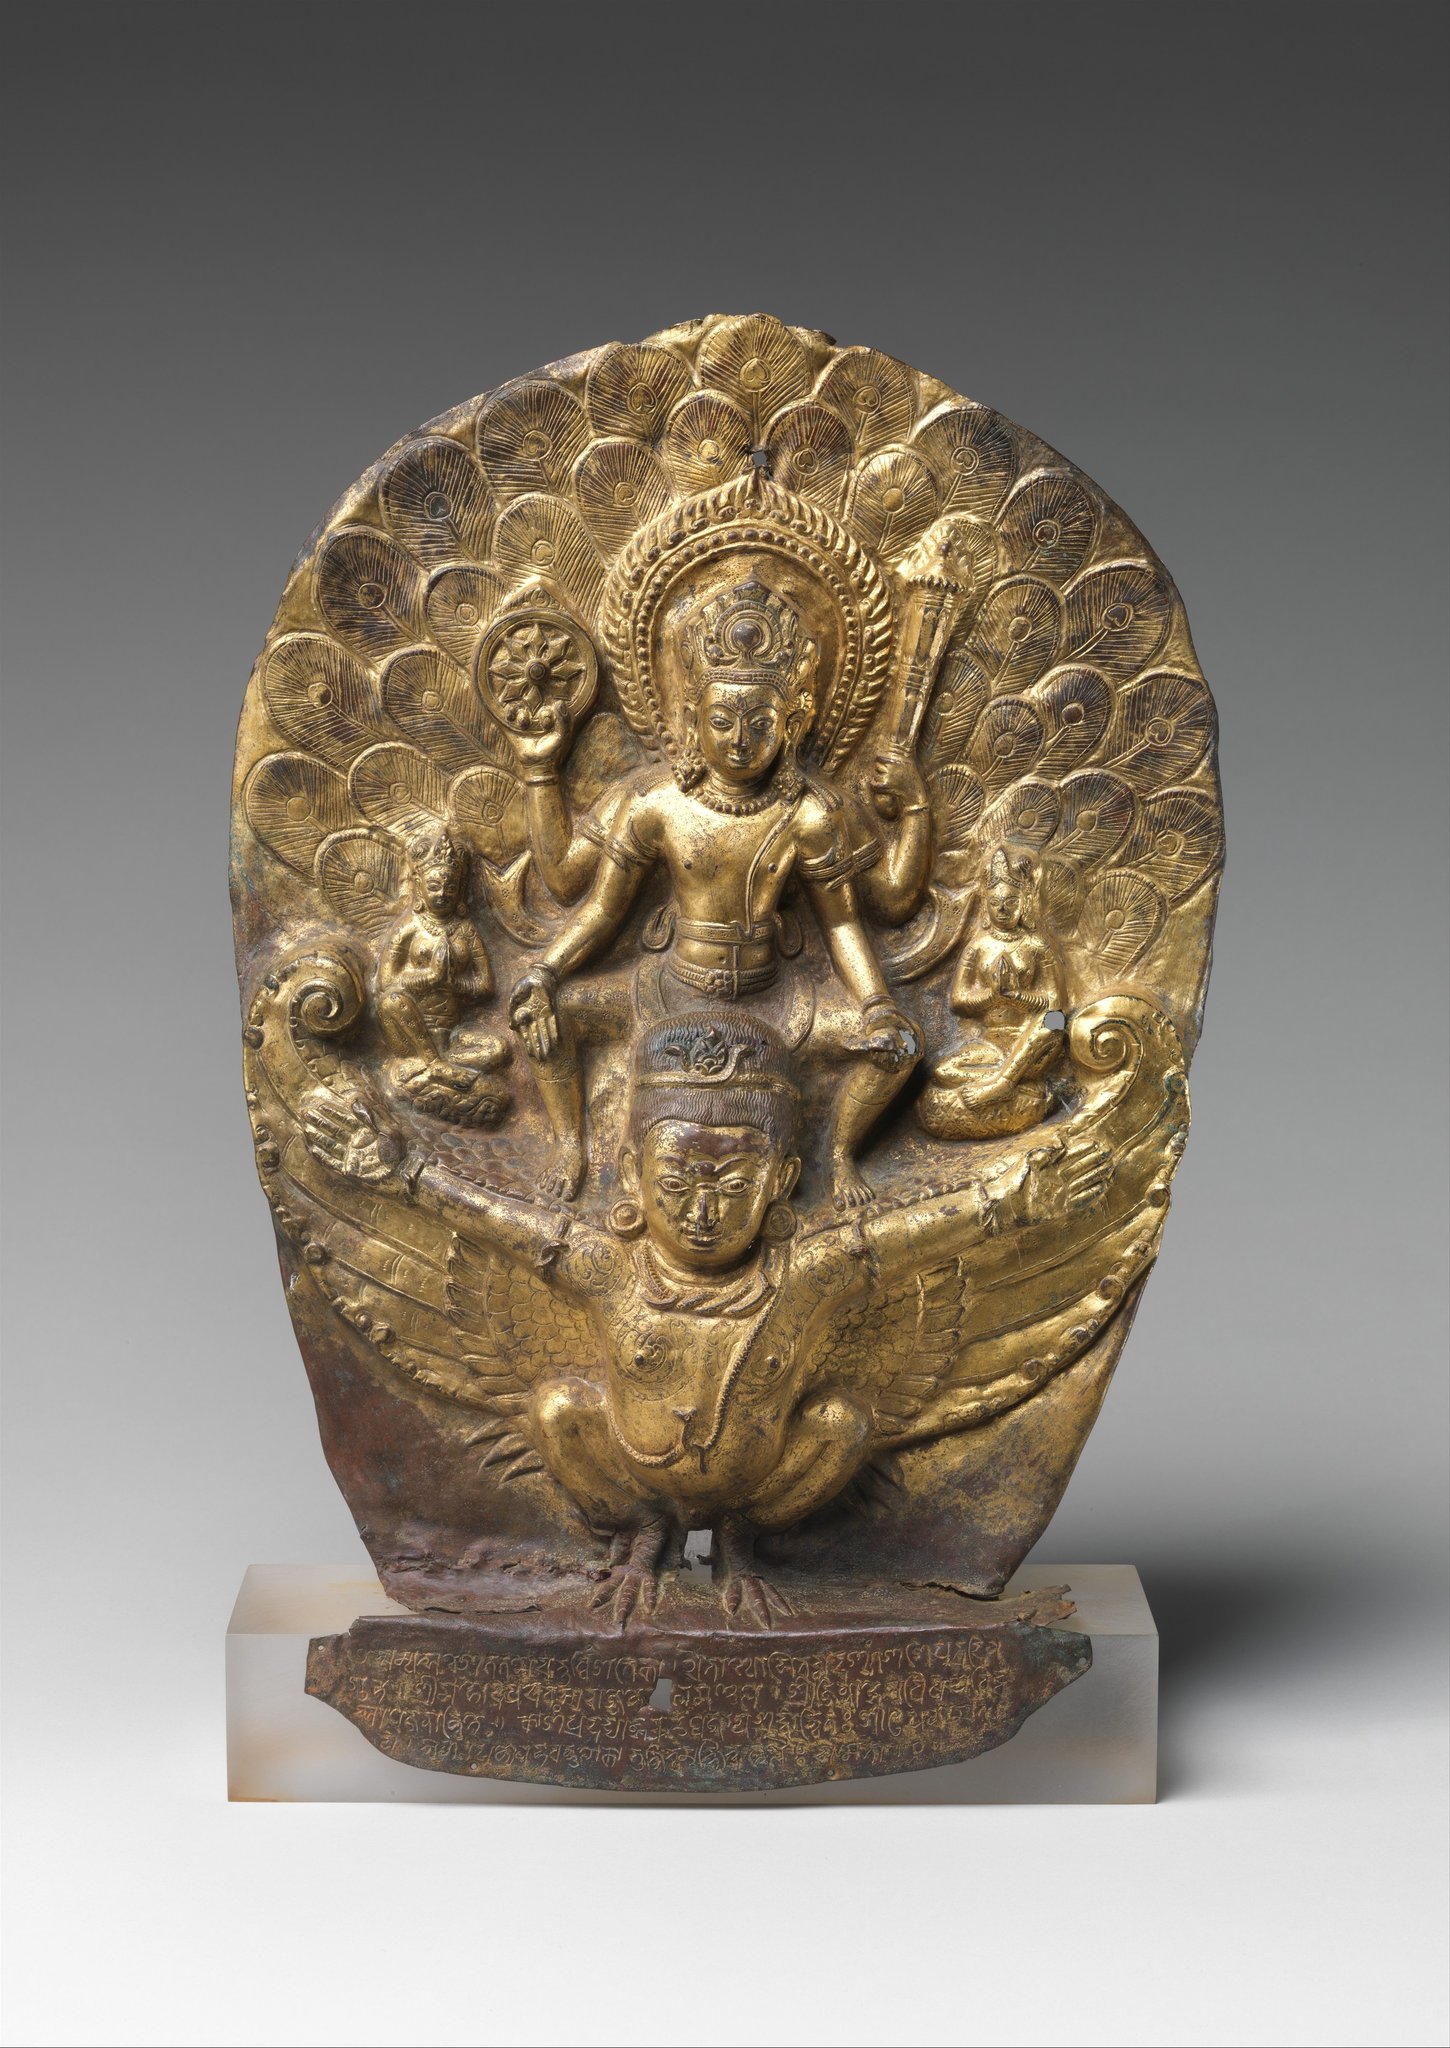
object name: figure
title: Vishnu Riding on Garuda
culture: nepali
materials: copper gilt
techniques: repoussé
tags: mythical creatures,vishnu,hinduism